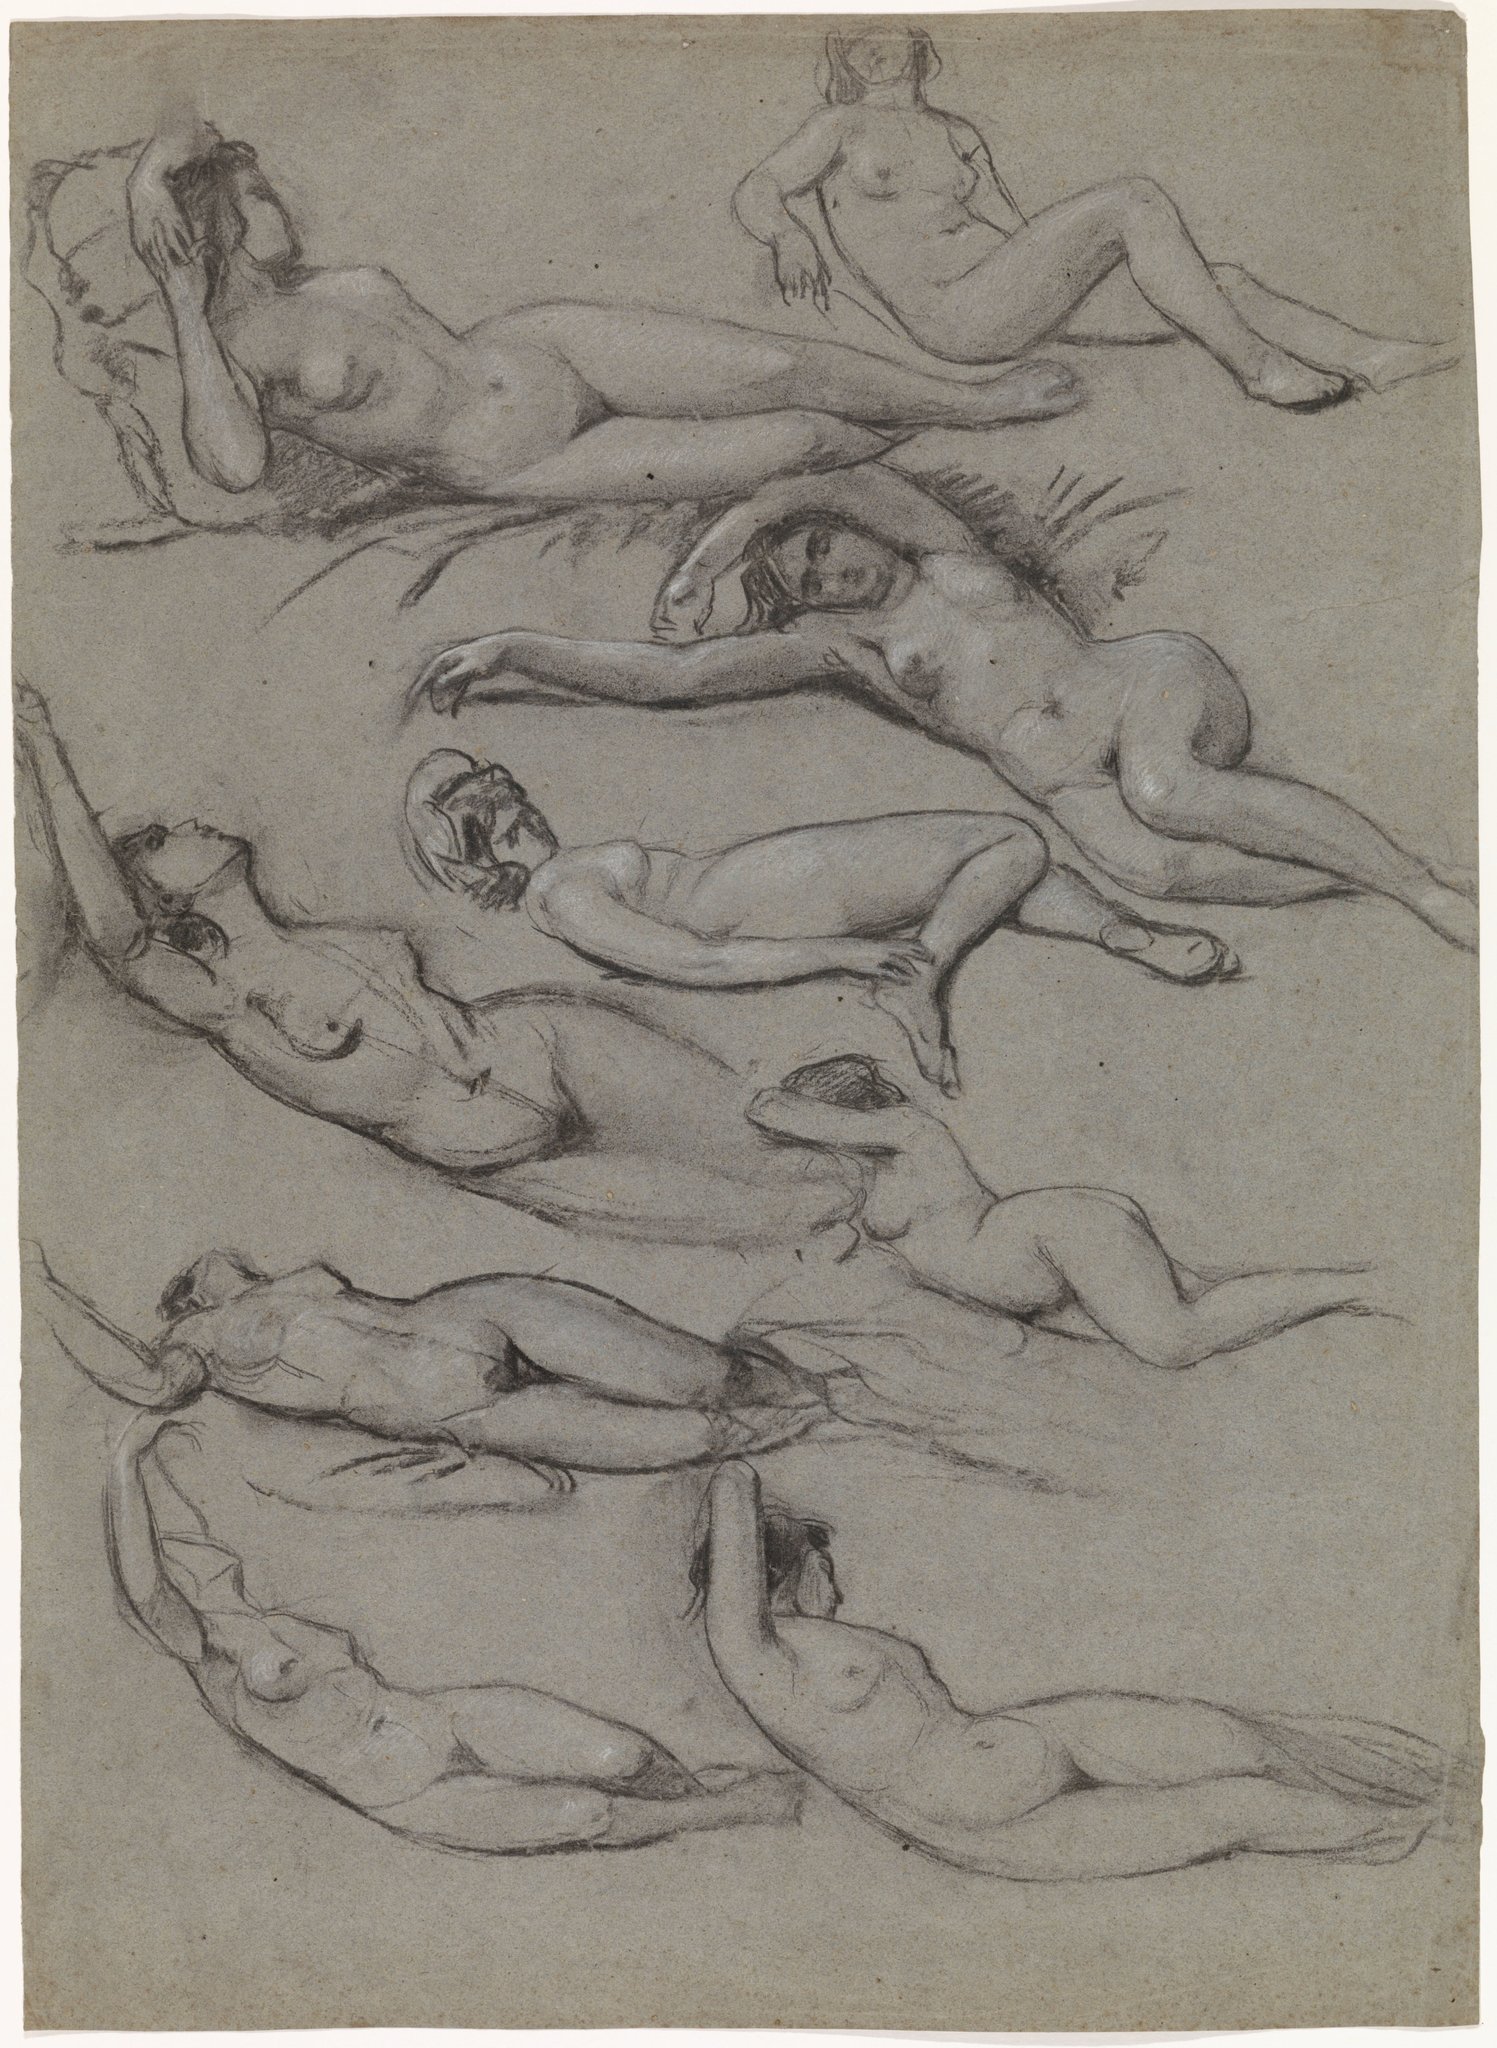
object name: drawing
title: Negen studies van een liggend vrouwelijk naakt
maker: thomas simon cool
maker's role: draughtsman, print maker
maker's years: 1831-1870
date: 1841-1870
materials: chalk, paper